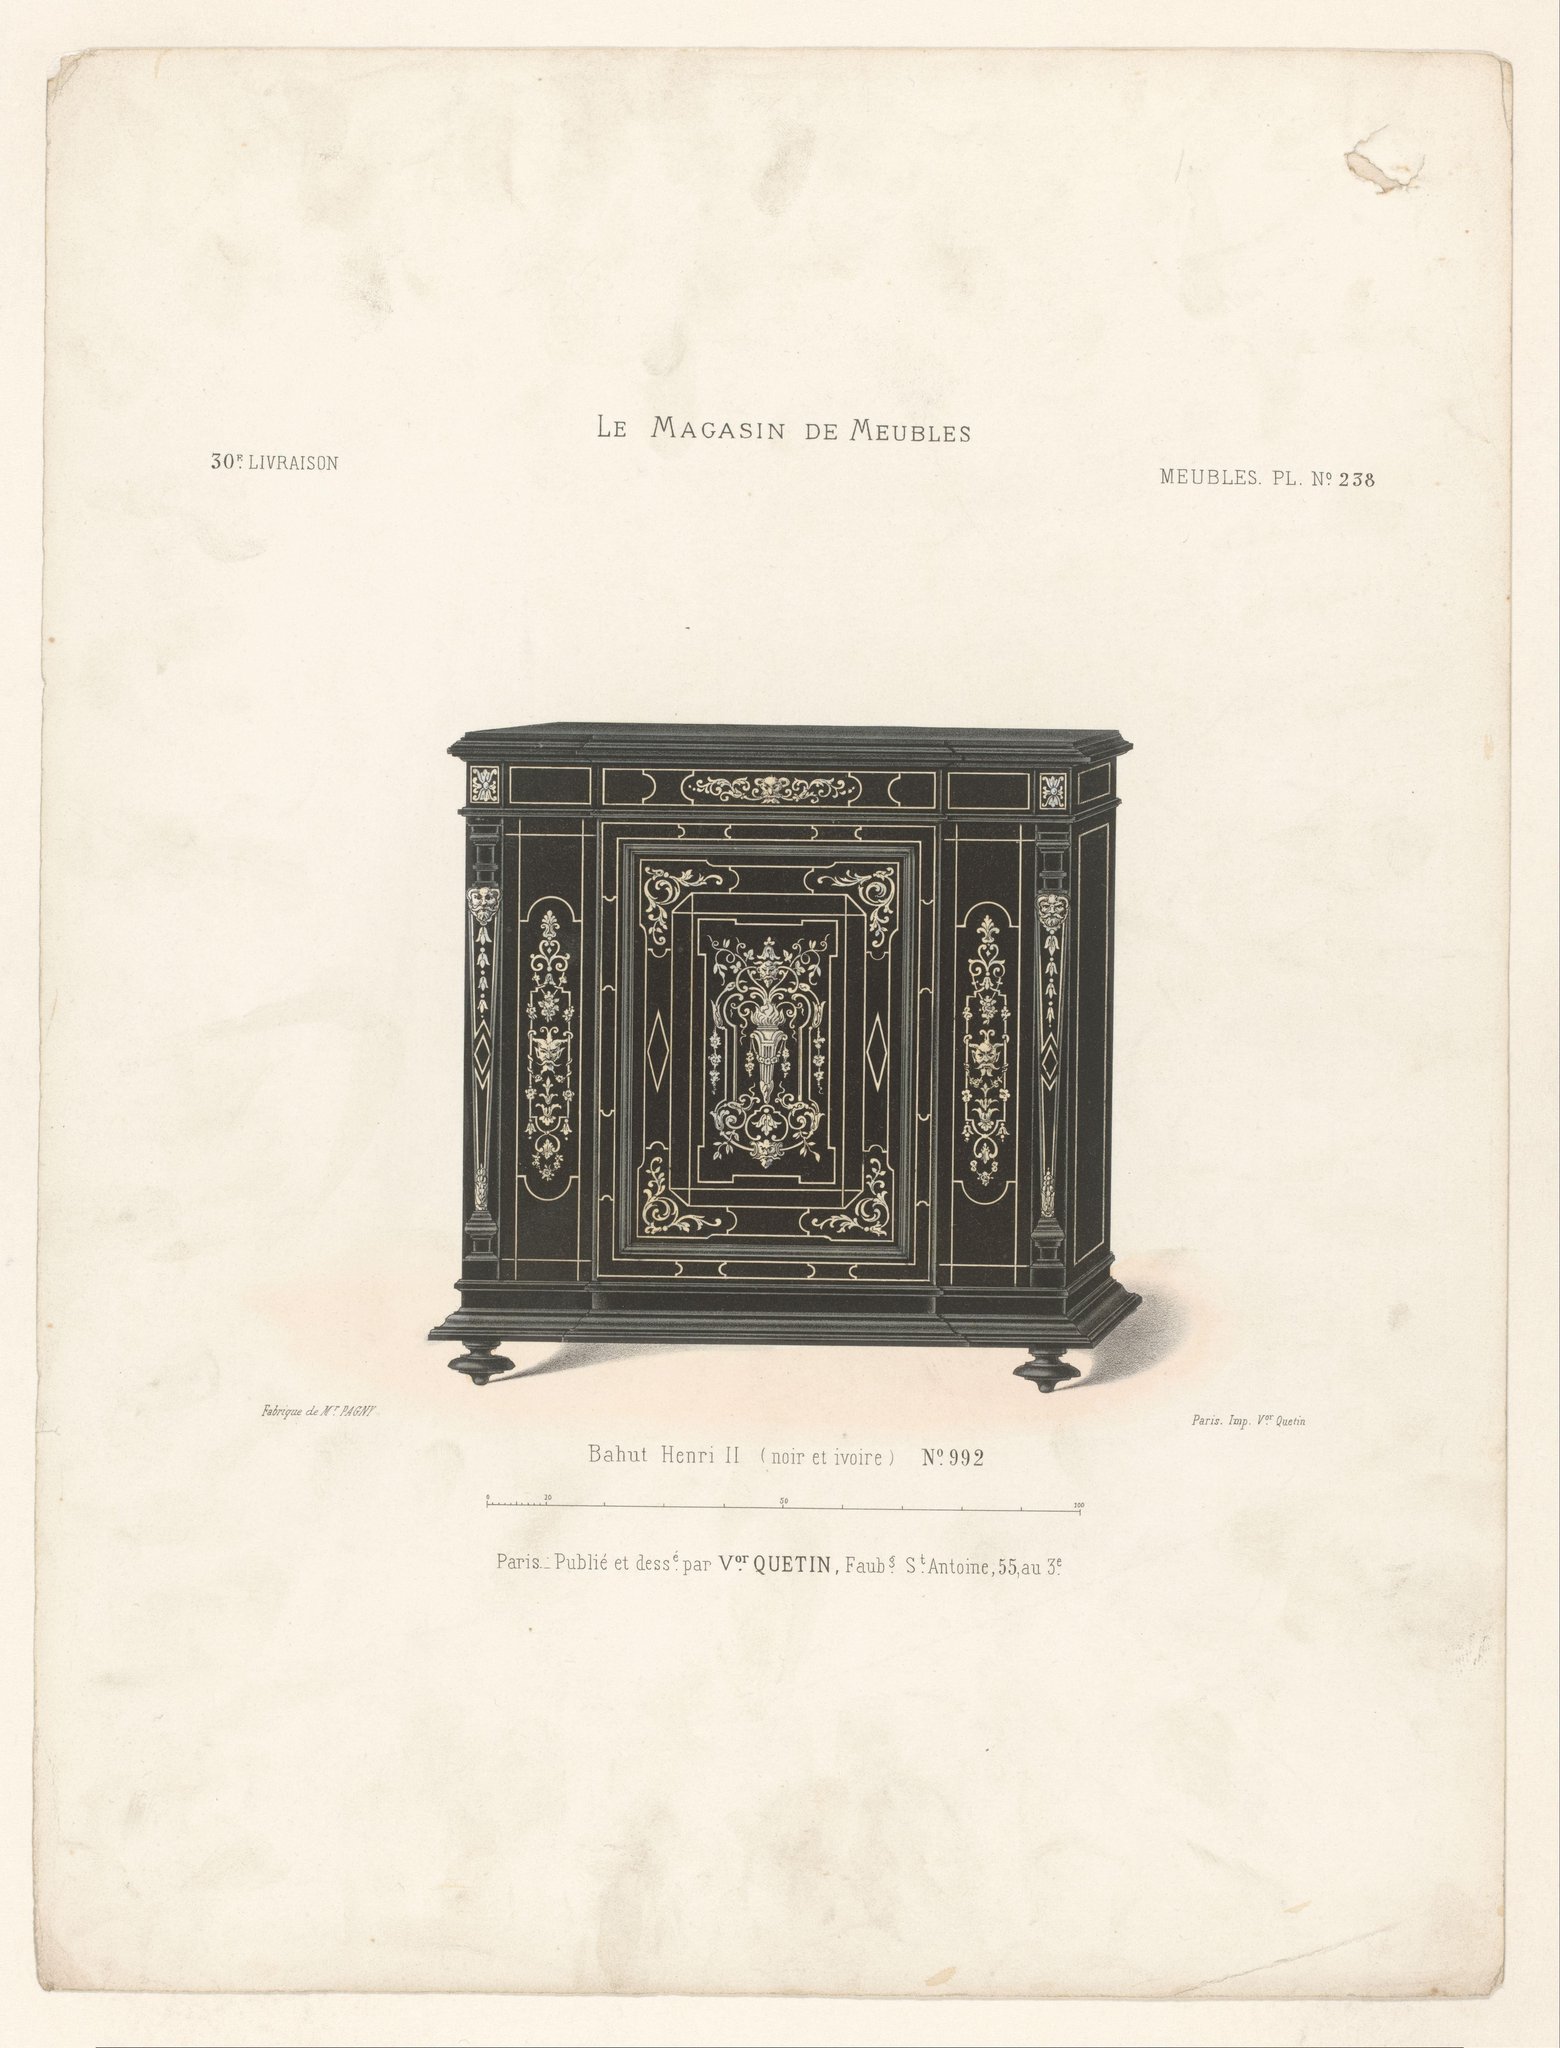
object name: print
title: Kast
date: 1832-1877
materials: paper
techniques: hand coloring, lithograph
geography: paris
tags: furniture for storage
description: Lage kast in de Hendrik II-stijl. Prent uit 30e Livraison.